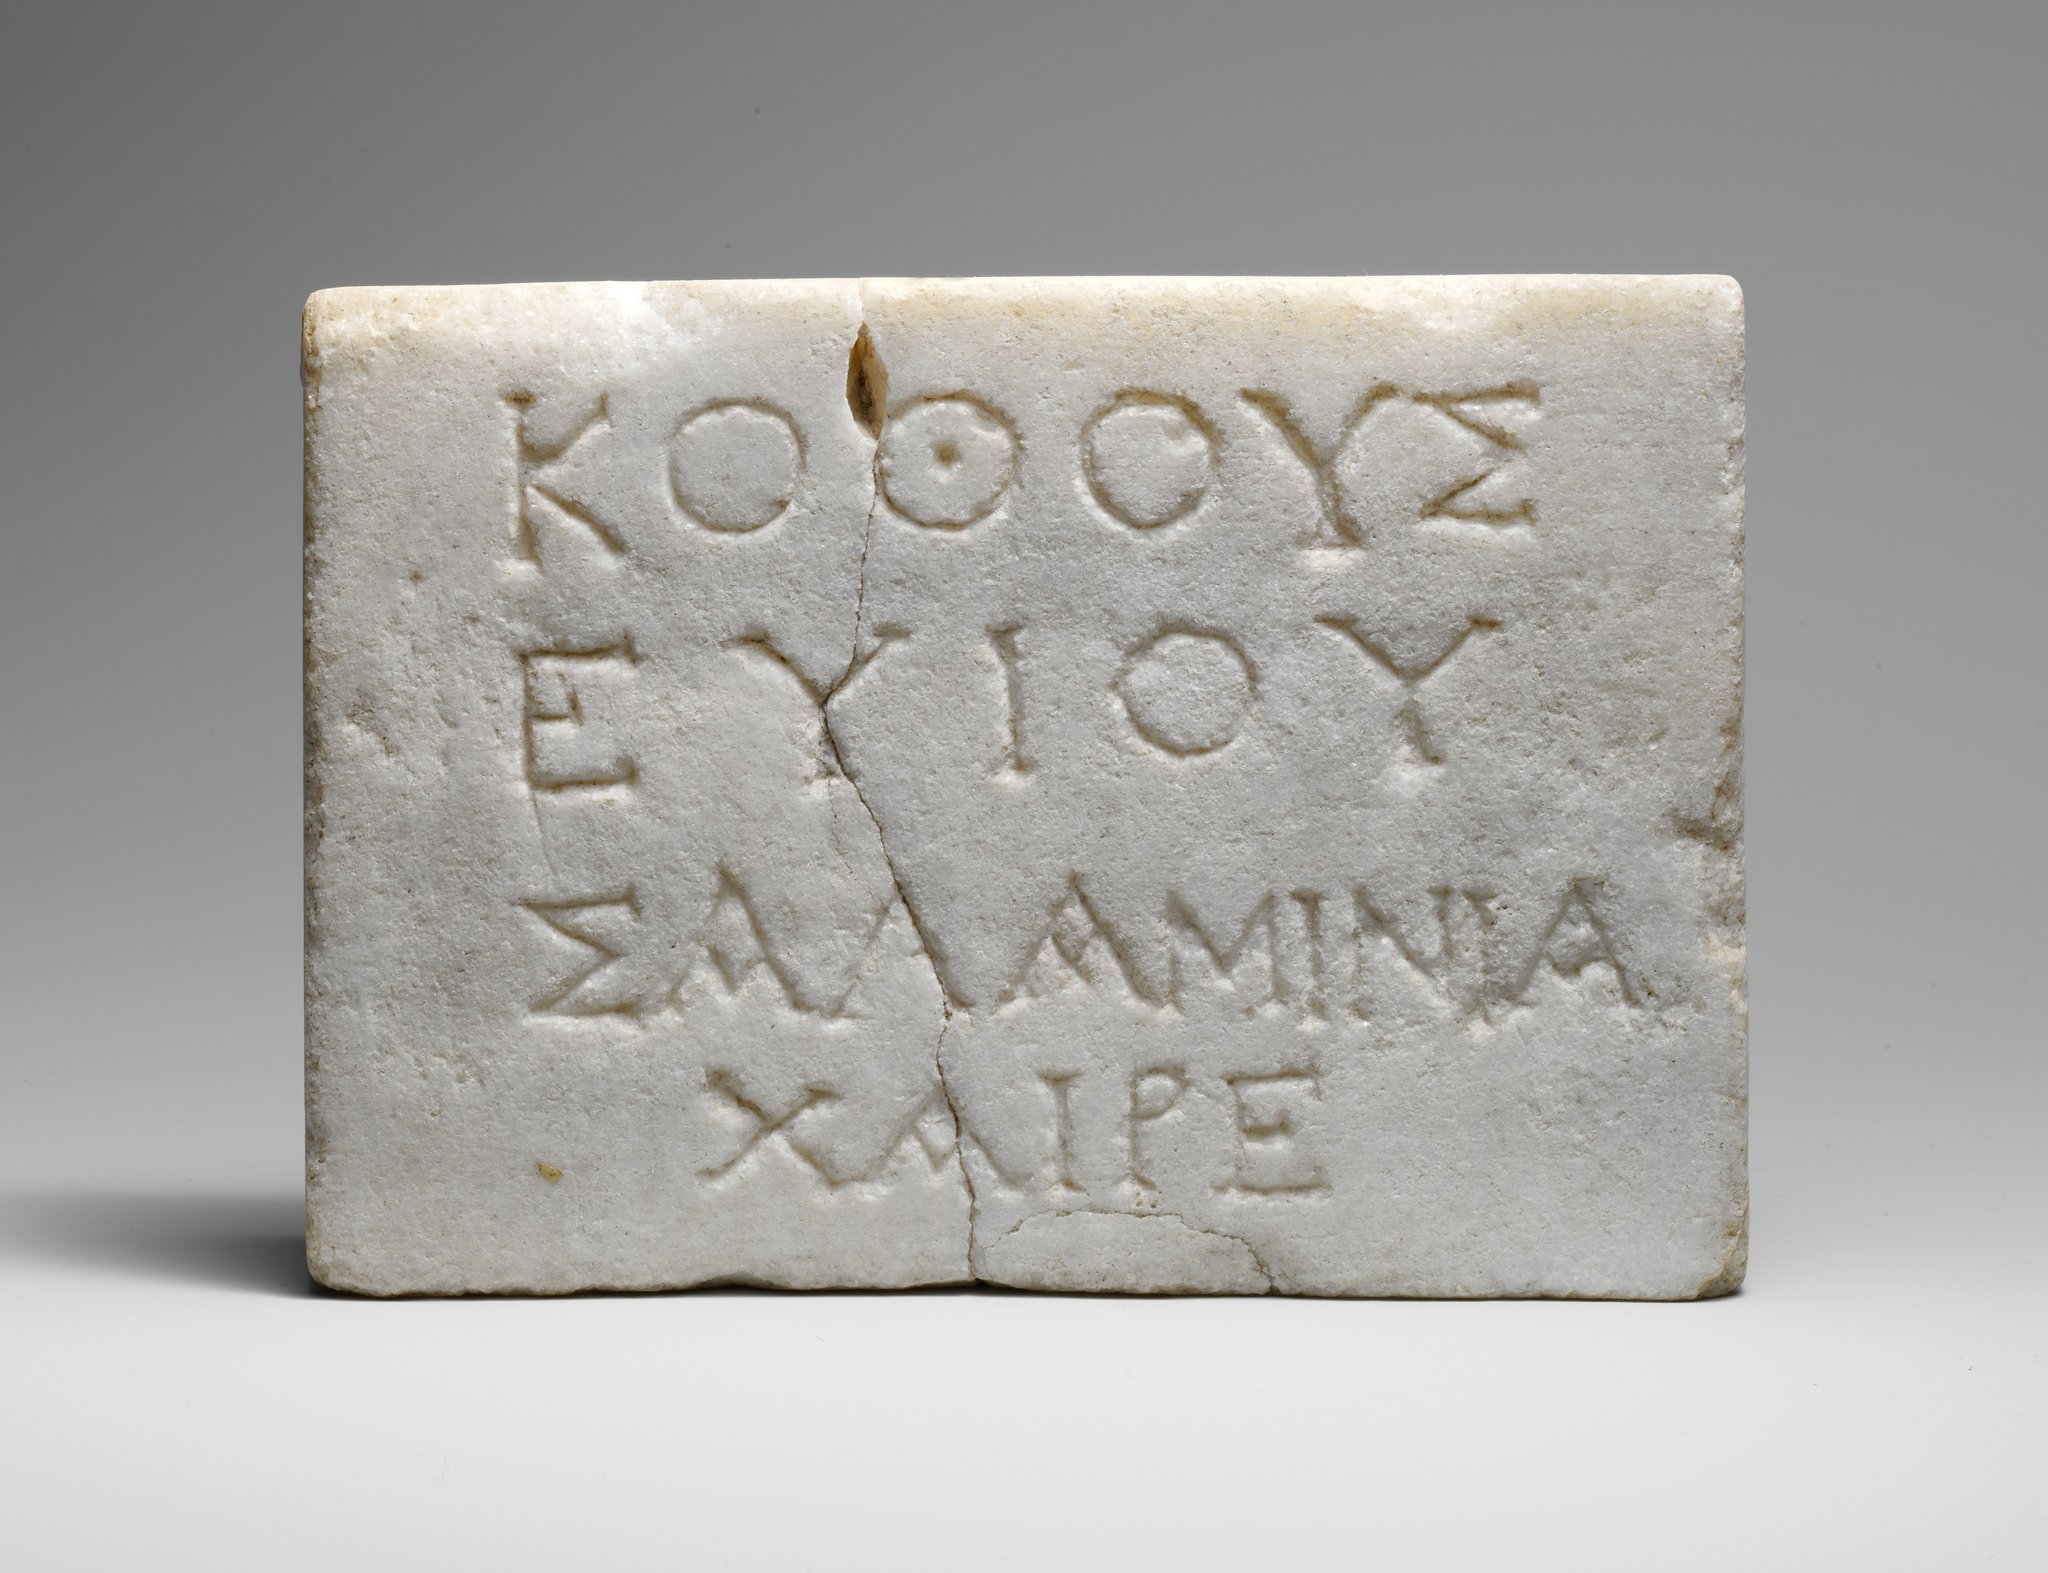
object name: tablet of salaminia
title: Inscribed marble plaque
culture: roman, cypriot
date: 1-100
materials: marble